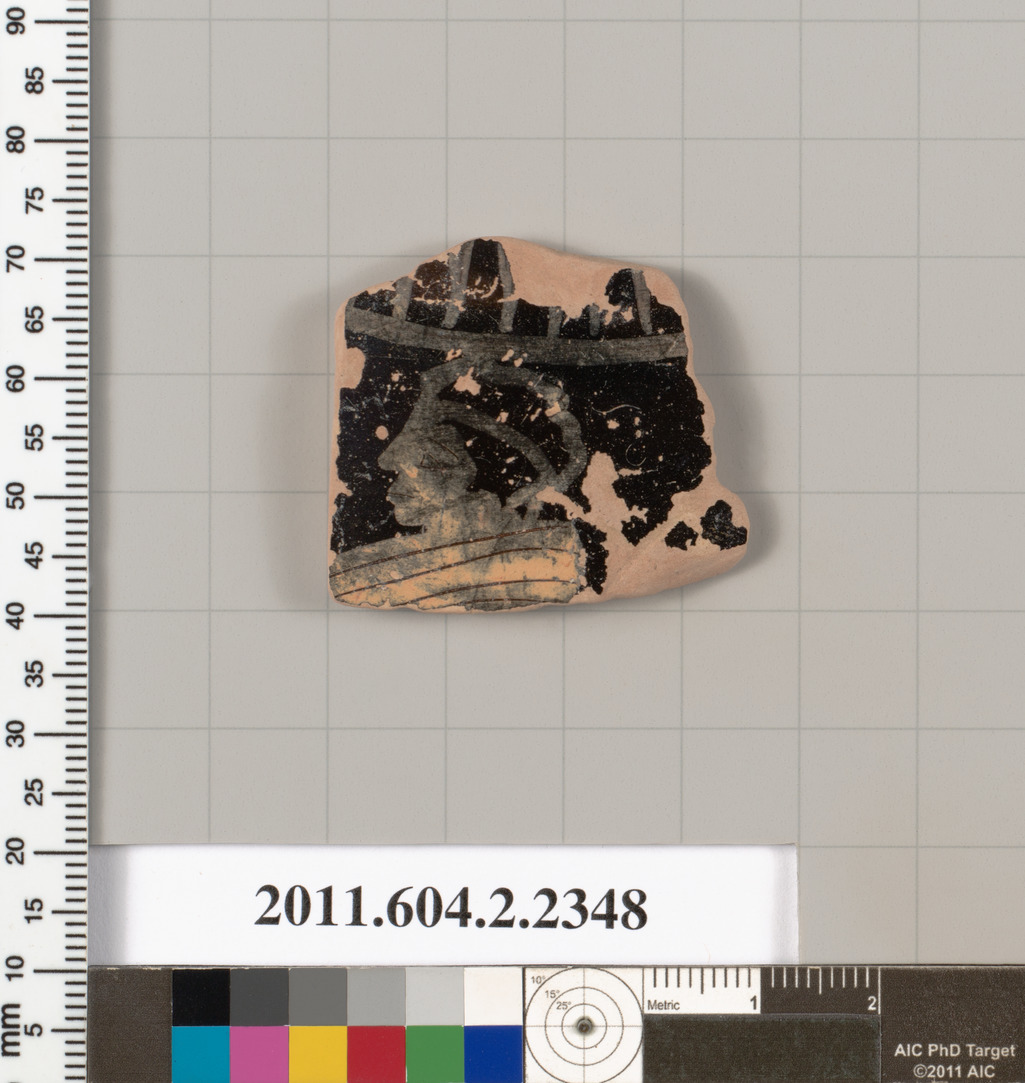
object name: lekythos fragment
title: Terracotta fragment of a squat lekythos (oil flask)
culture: greek, attic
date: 425-401 BCE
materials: terracotta